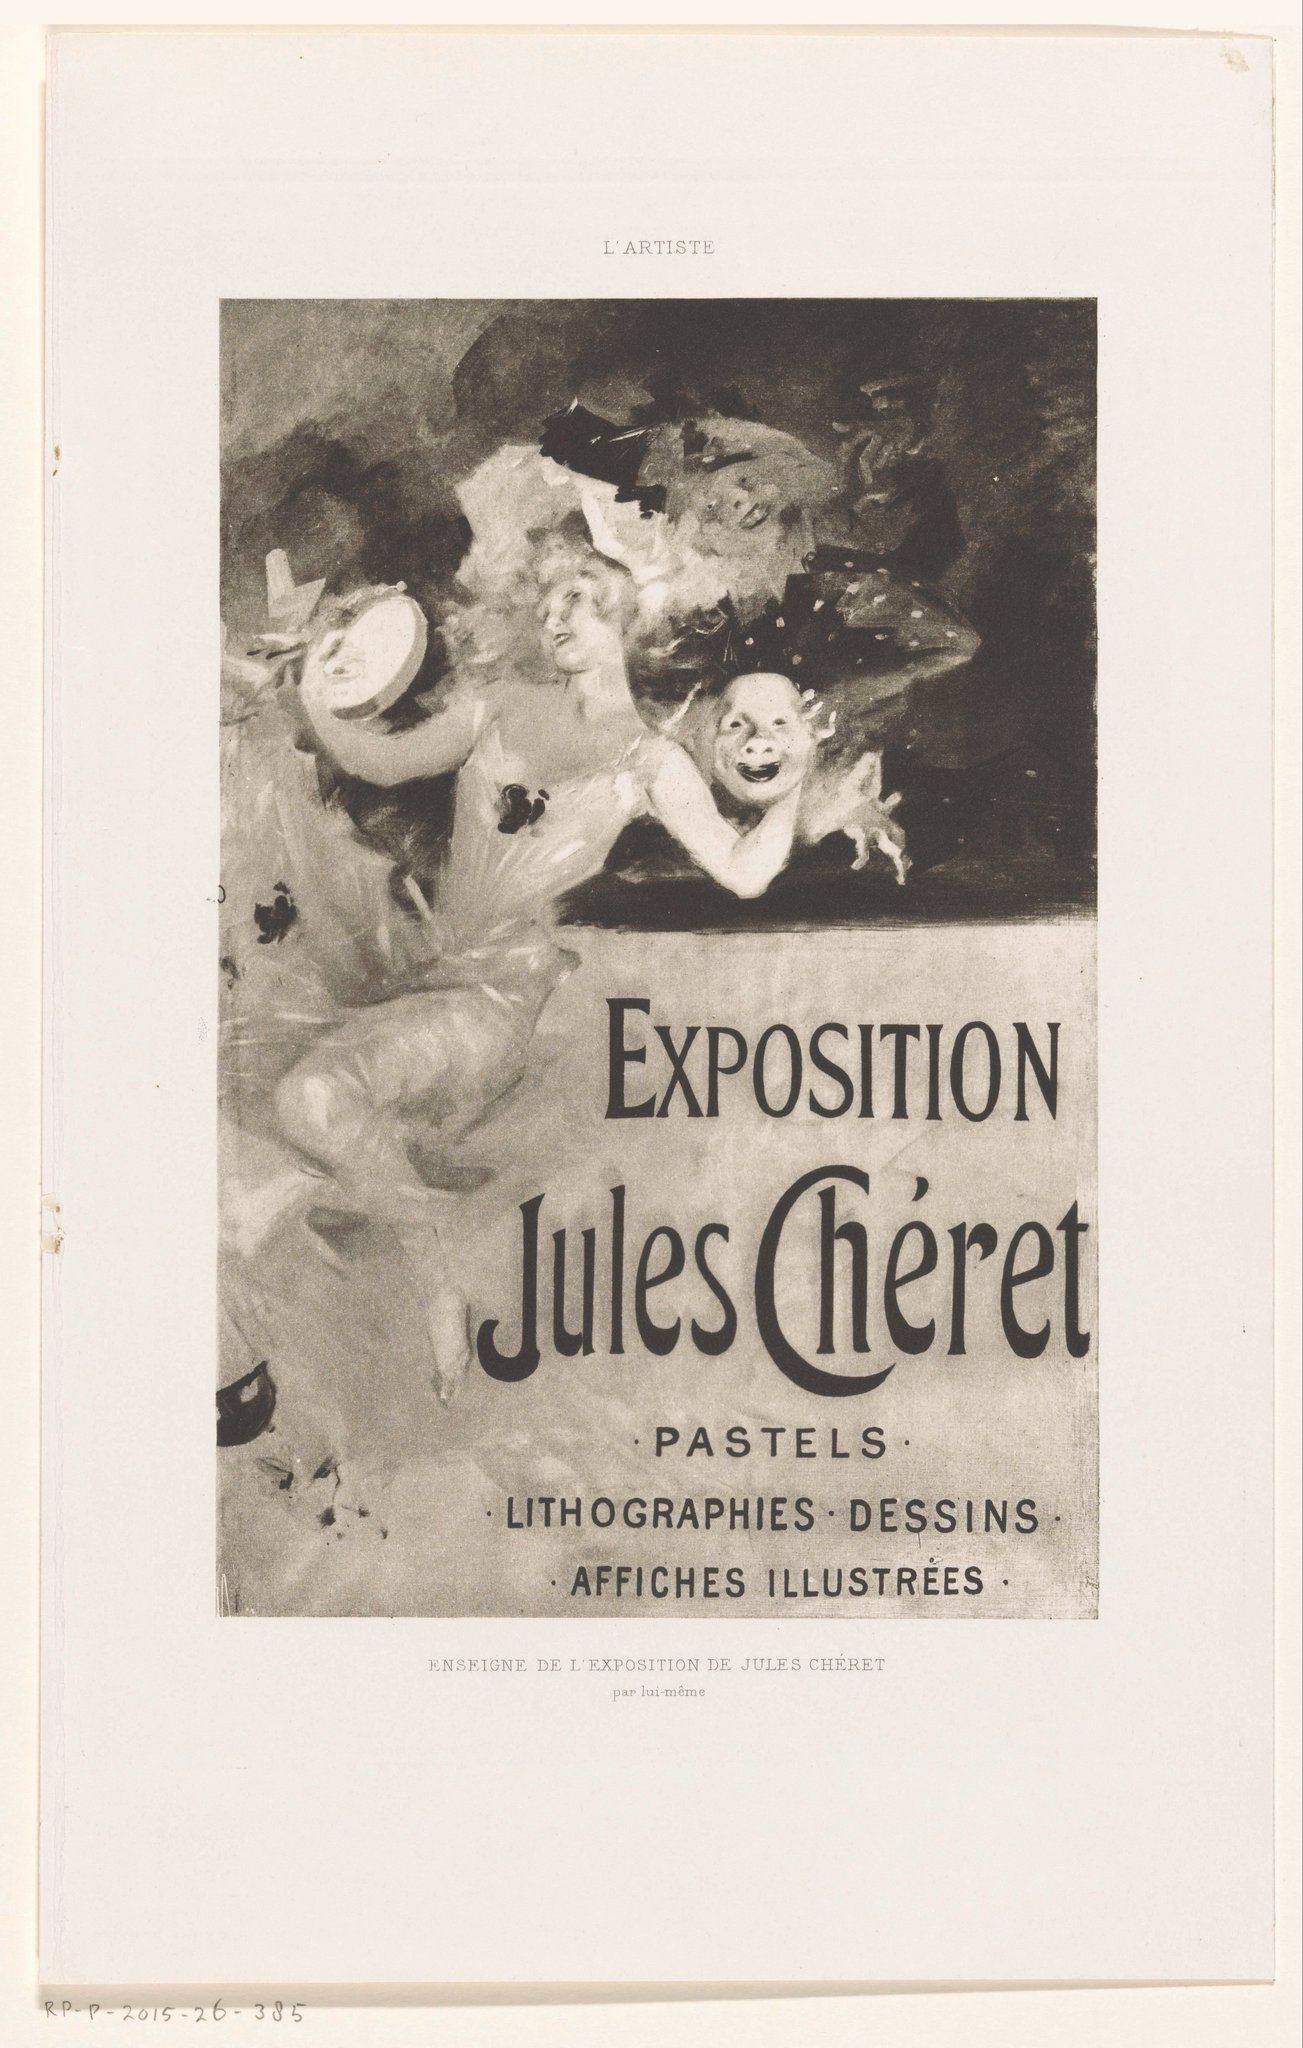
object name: illustration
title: Dansende vrouw met masker en tamboerijn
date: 1889-1890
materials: paper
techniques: photoaquatint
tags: mask, woman dancing alone, tambourine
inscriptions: collector's mark: Lugt 4779, collector's mark: Lugt 2228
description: Advertentie voor een expositie met werk van Jules Chéret.